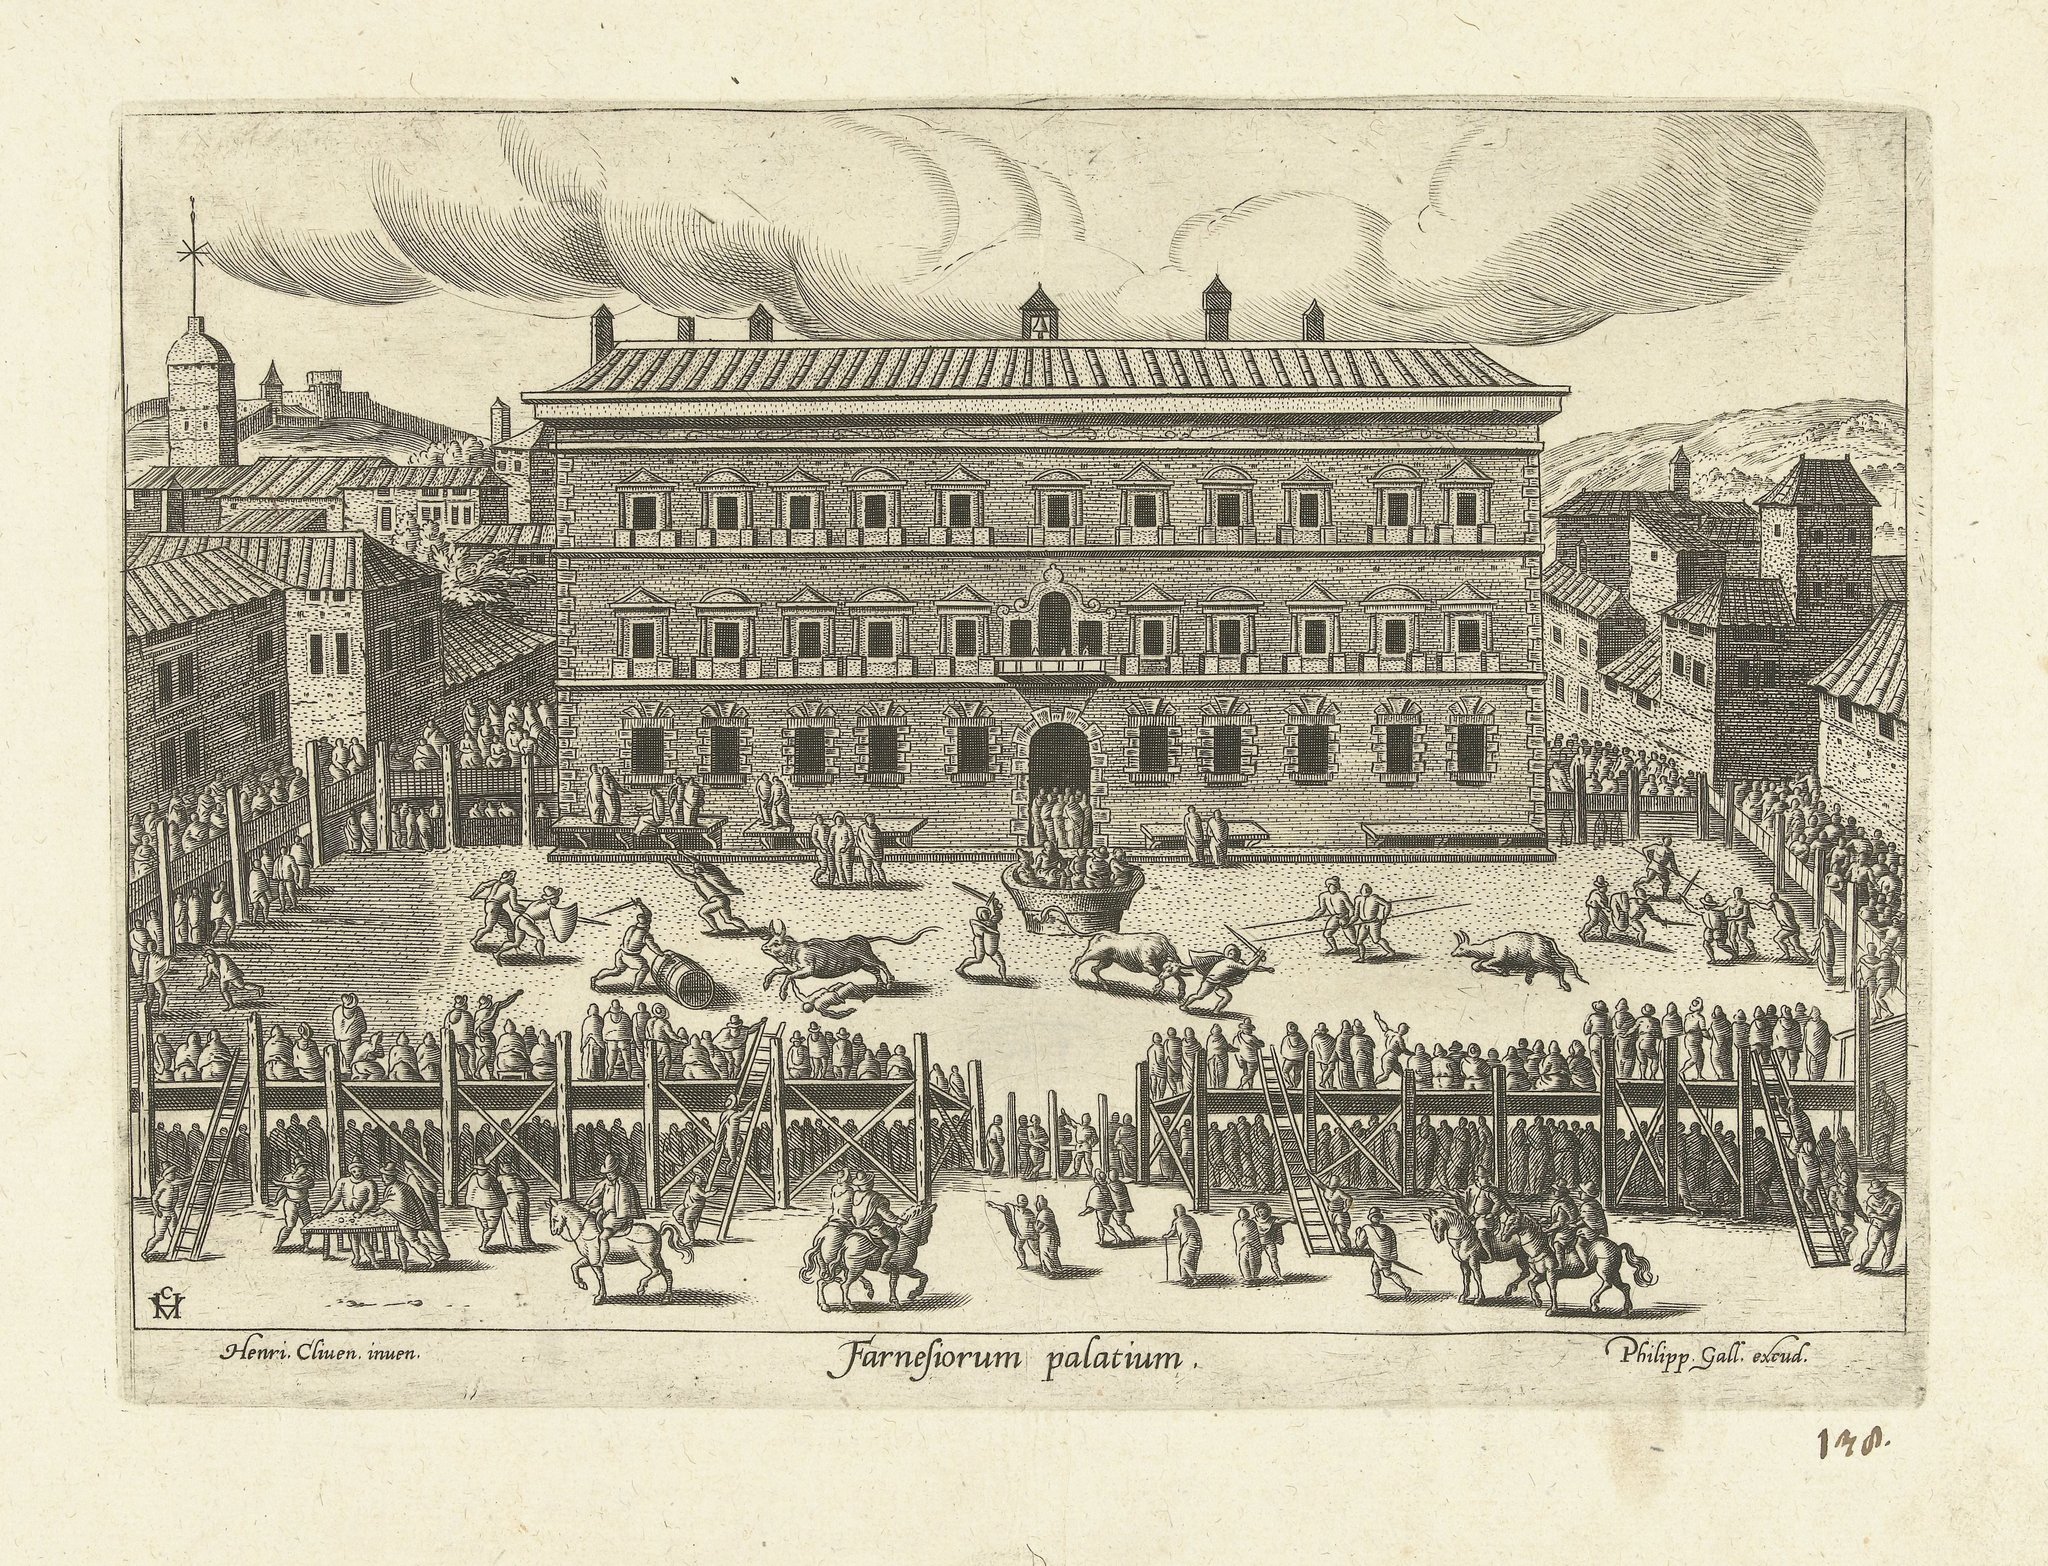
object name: print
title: Farnesiorum palatium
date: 1585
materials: paper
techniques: engraving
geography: haarlem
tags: bullfight, joust, tilt, landscape with tower or castle (+ city(-scape) with figures, staffage)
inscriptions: collector's mark: Lugt 2228, number: ‘130’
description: Gezicht op het Palazzo Farnese en het Piazza Farnese. Er is een toernooi aan de gang met stierengevechten. Er zijn vele toeschouwers. De prent is deel van een serie die verschillende plaatsen in het Middellandse Zeegebied afbeeldt.